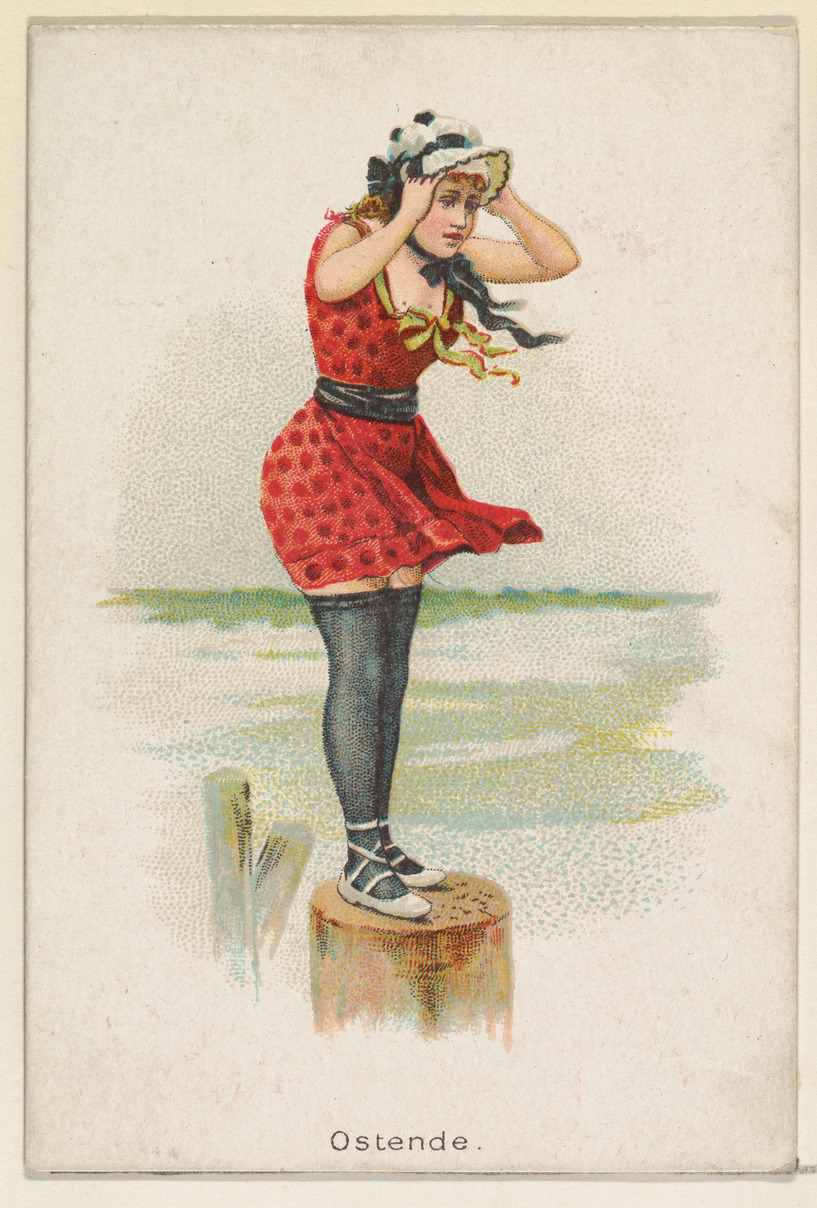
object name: print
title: Ostende, from the Beautiful Bathers series (N192) issued by Wm. S. Kimball & Co.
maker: william s. kimball & company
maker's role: publisher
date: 1889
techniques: color lithograph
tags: women